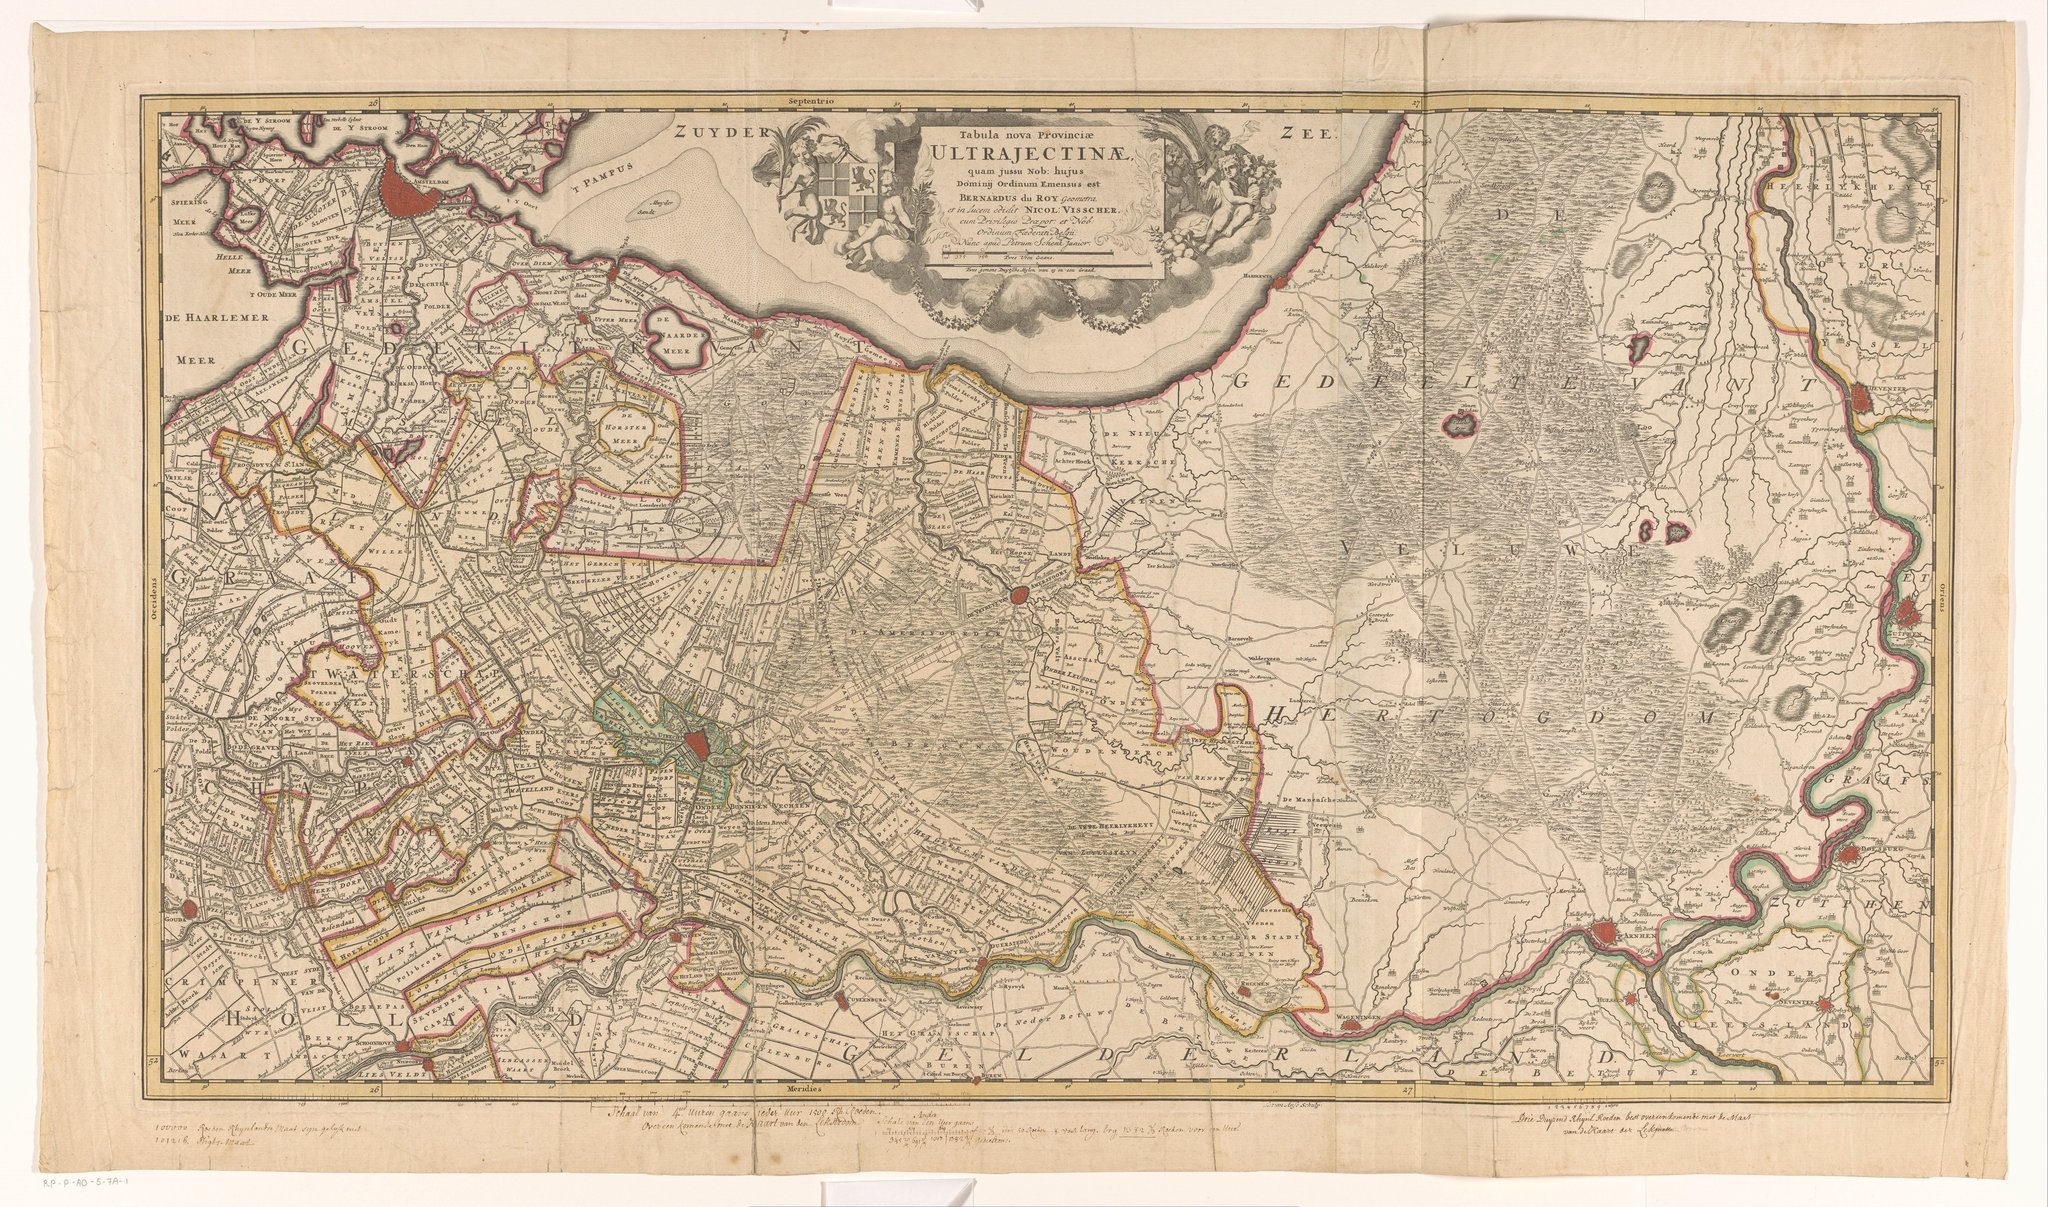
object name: map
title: Kaart van de provincie Utrecht en de Veluwe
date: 1679-1682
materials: ink, paper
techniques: engraving, etching, pen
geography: utrecht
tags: coat of arms (as symbol of the state, etc.), maps of separate countries or regions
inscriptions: inscription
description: Boven in het midden een cartouche met de titel en twee schaalstokken: Twee uren gaans; Twee gemene Duytsche mylen van 15 in een graad. Daaromheen het wapen van de provincie Utrecht en putti. Gradenverdeling langs de randen. Binnen en buiten de plaatrand zijn verschillende handgeschreven schaalstokken toegevoegd.